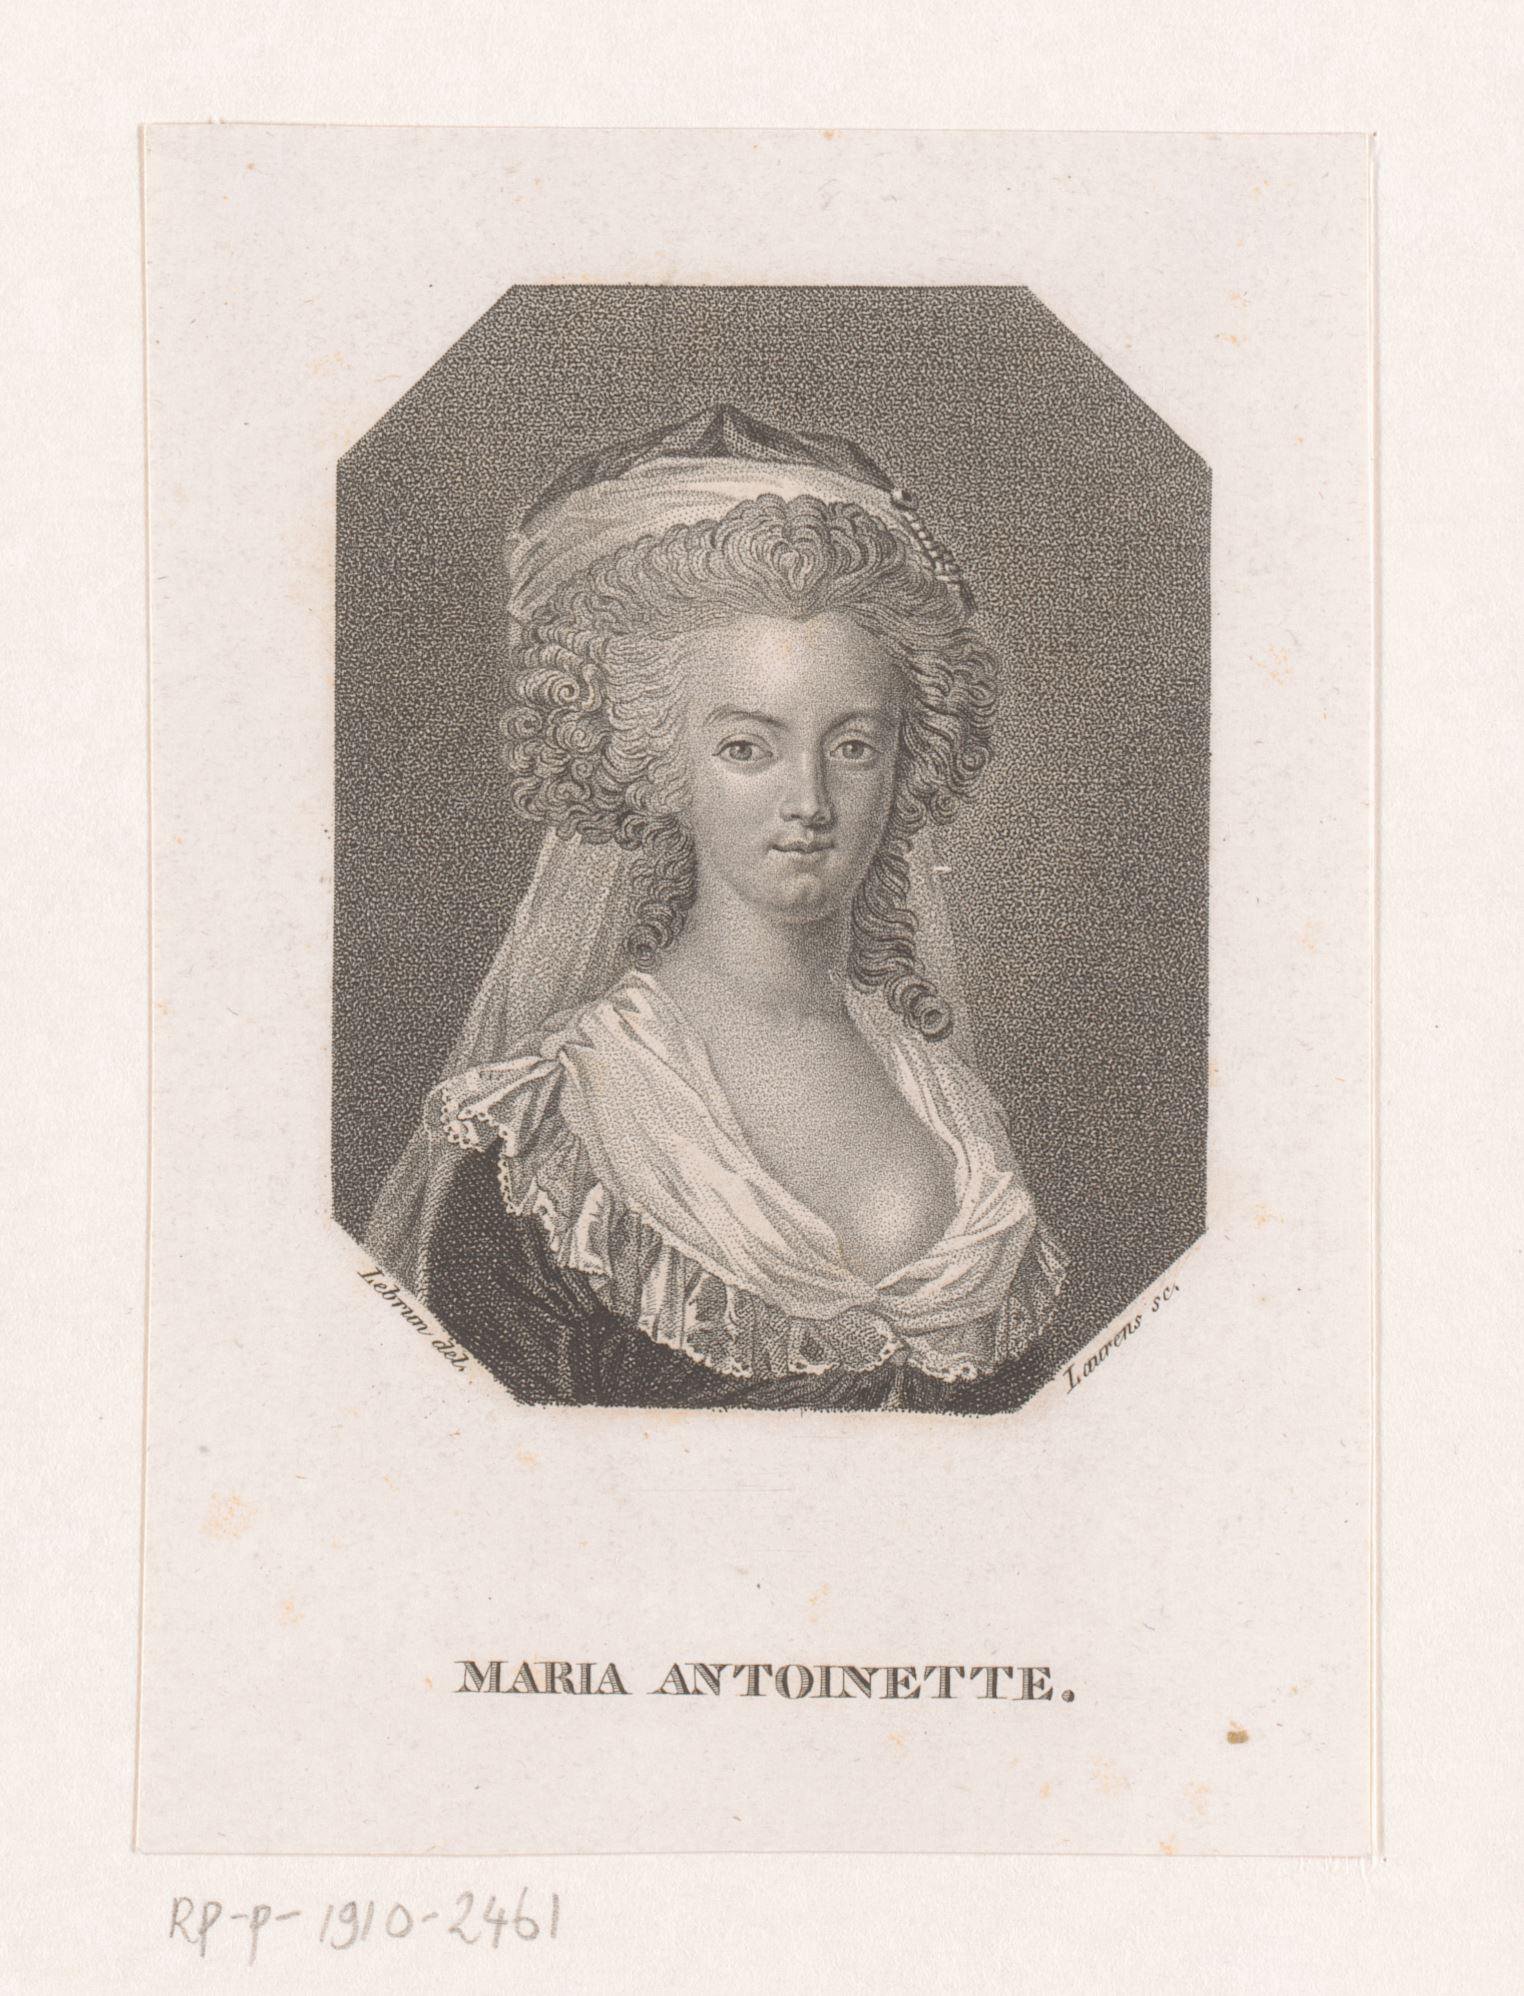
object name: print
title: Portret van Marie Antoinette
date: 1804-1832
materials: paper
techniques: stippling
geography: zwickau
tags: paris, marie antoinette, historical persons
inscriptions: collector's mark: Lugt 2228